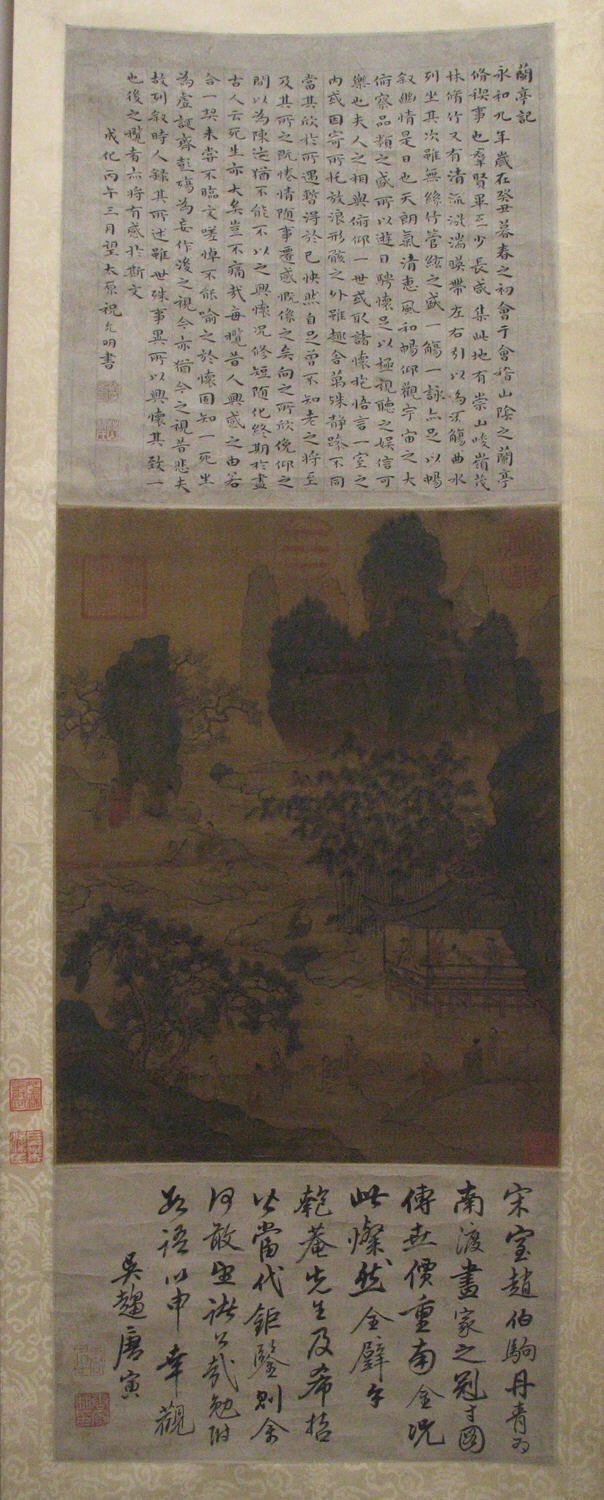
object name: hanging scroll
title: Orchid Pavilion or Lanting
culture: chinese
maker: unidentified artist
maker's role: artist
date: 1368-1911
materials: ink, silk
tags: landscapes,pavilions